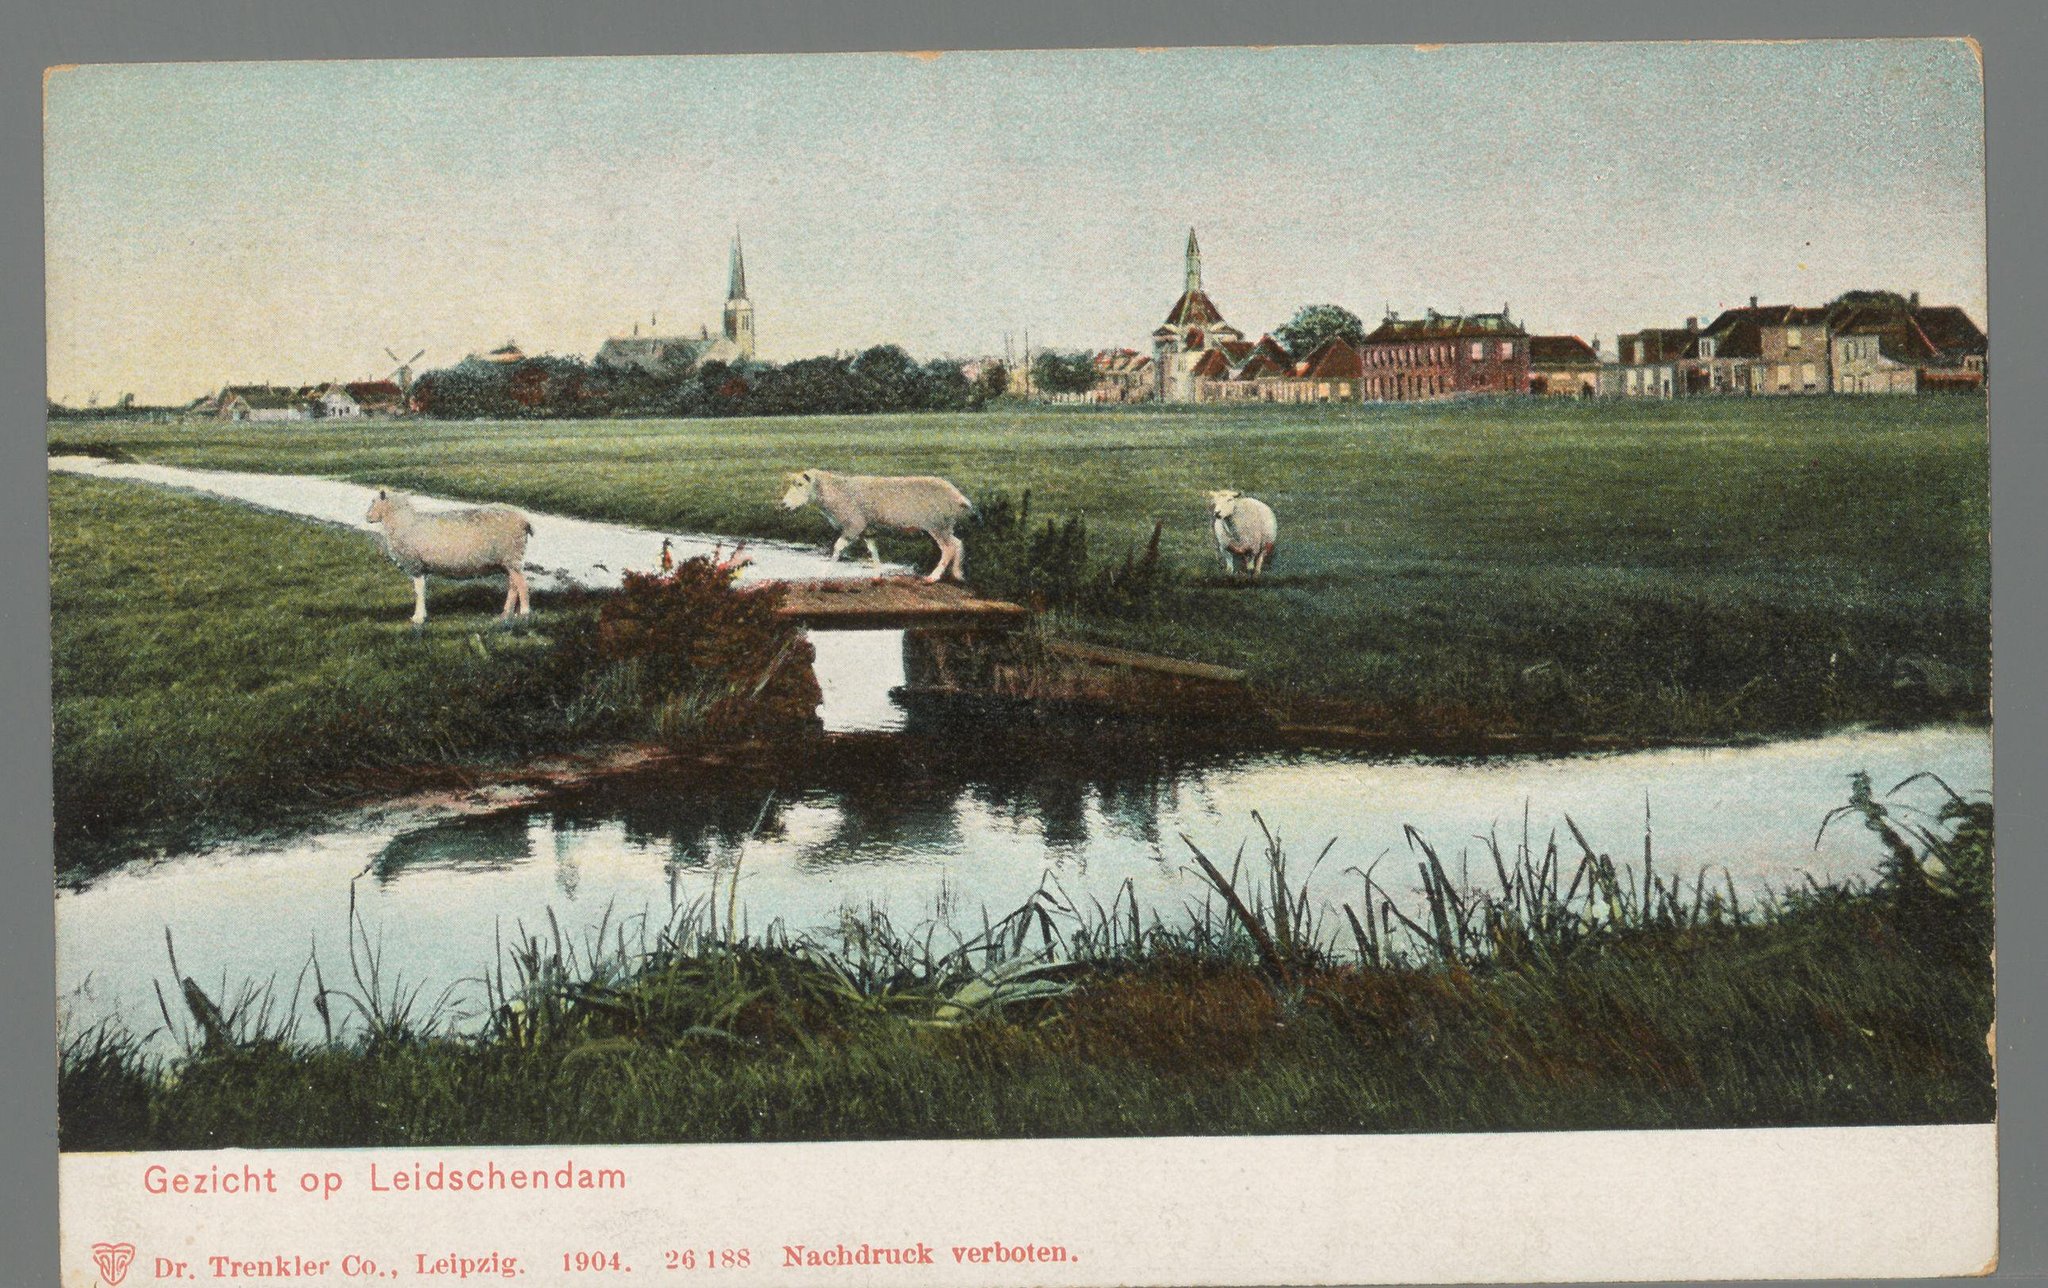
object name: photomechanical print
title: Gezicht op Leidschendam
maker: Anonymous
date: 1904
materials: cardboard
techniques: lithograph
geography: leipzig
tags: city-view, and landscape with man-made constructions, meadow, pasture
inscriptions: date